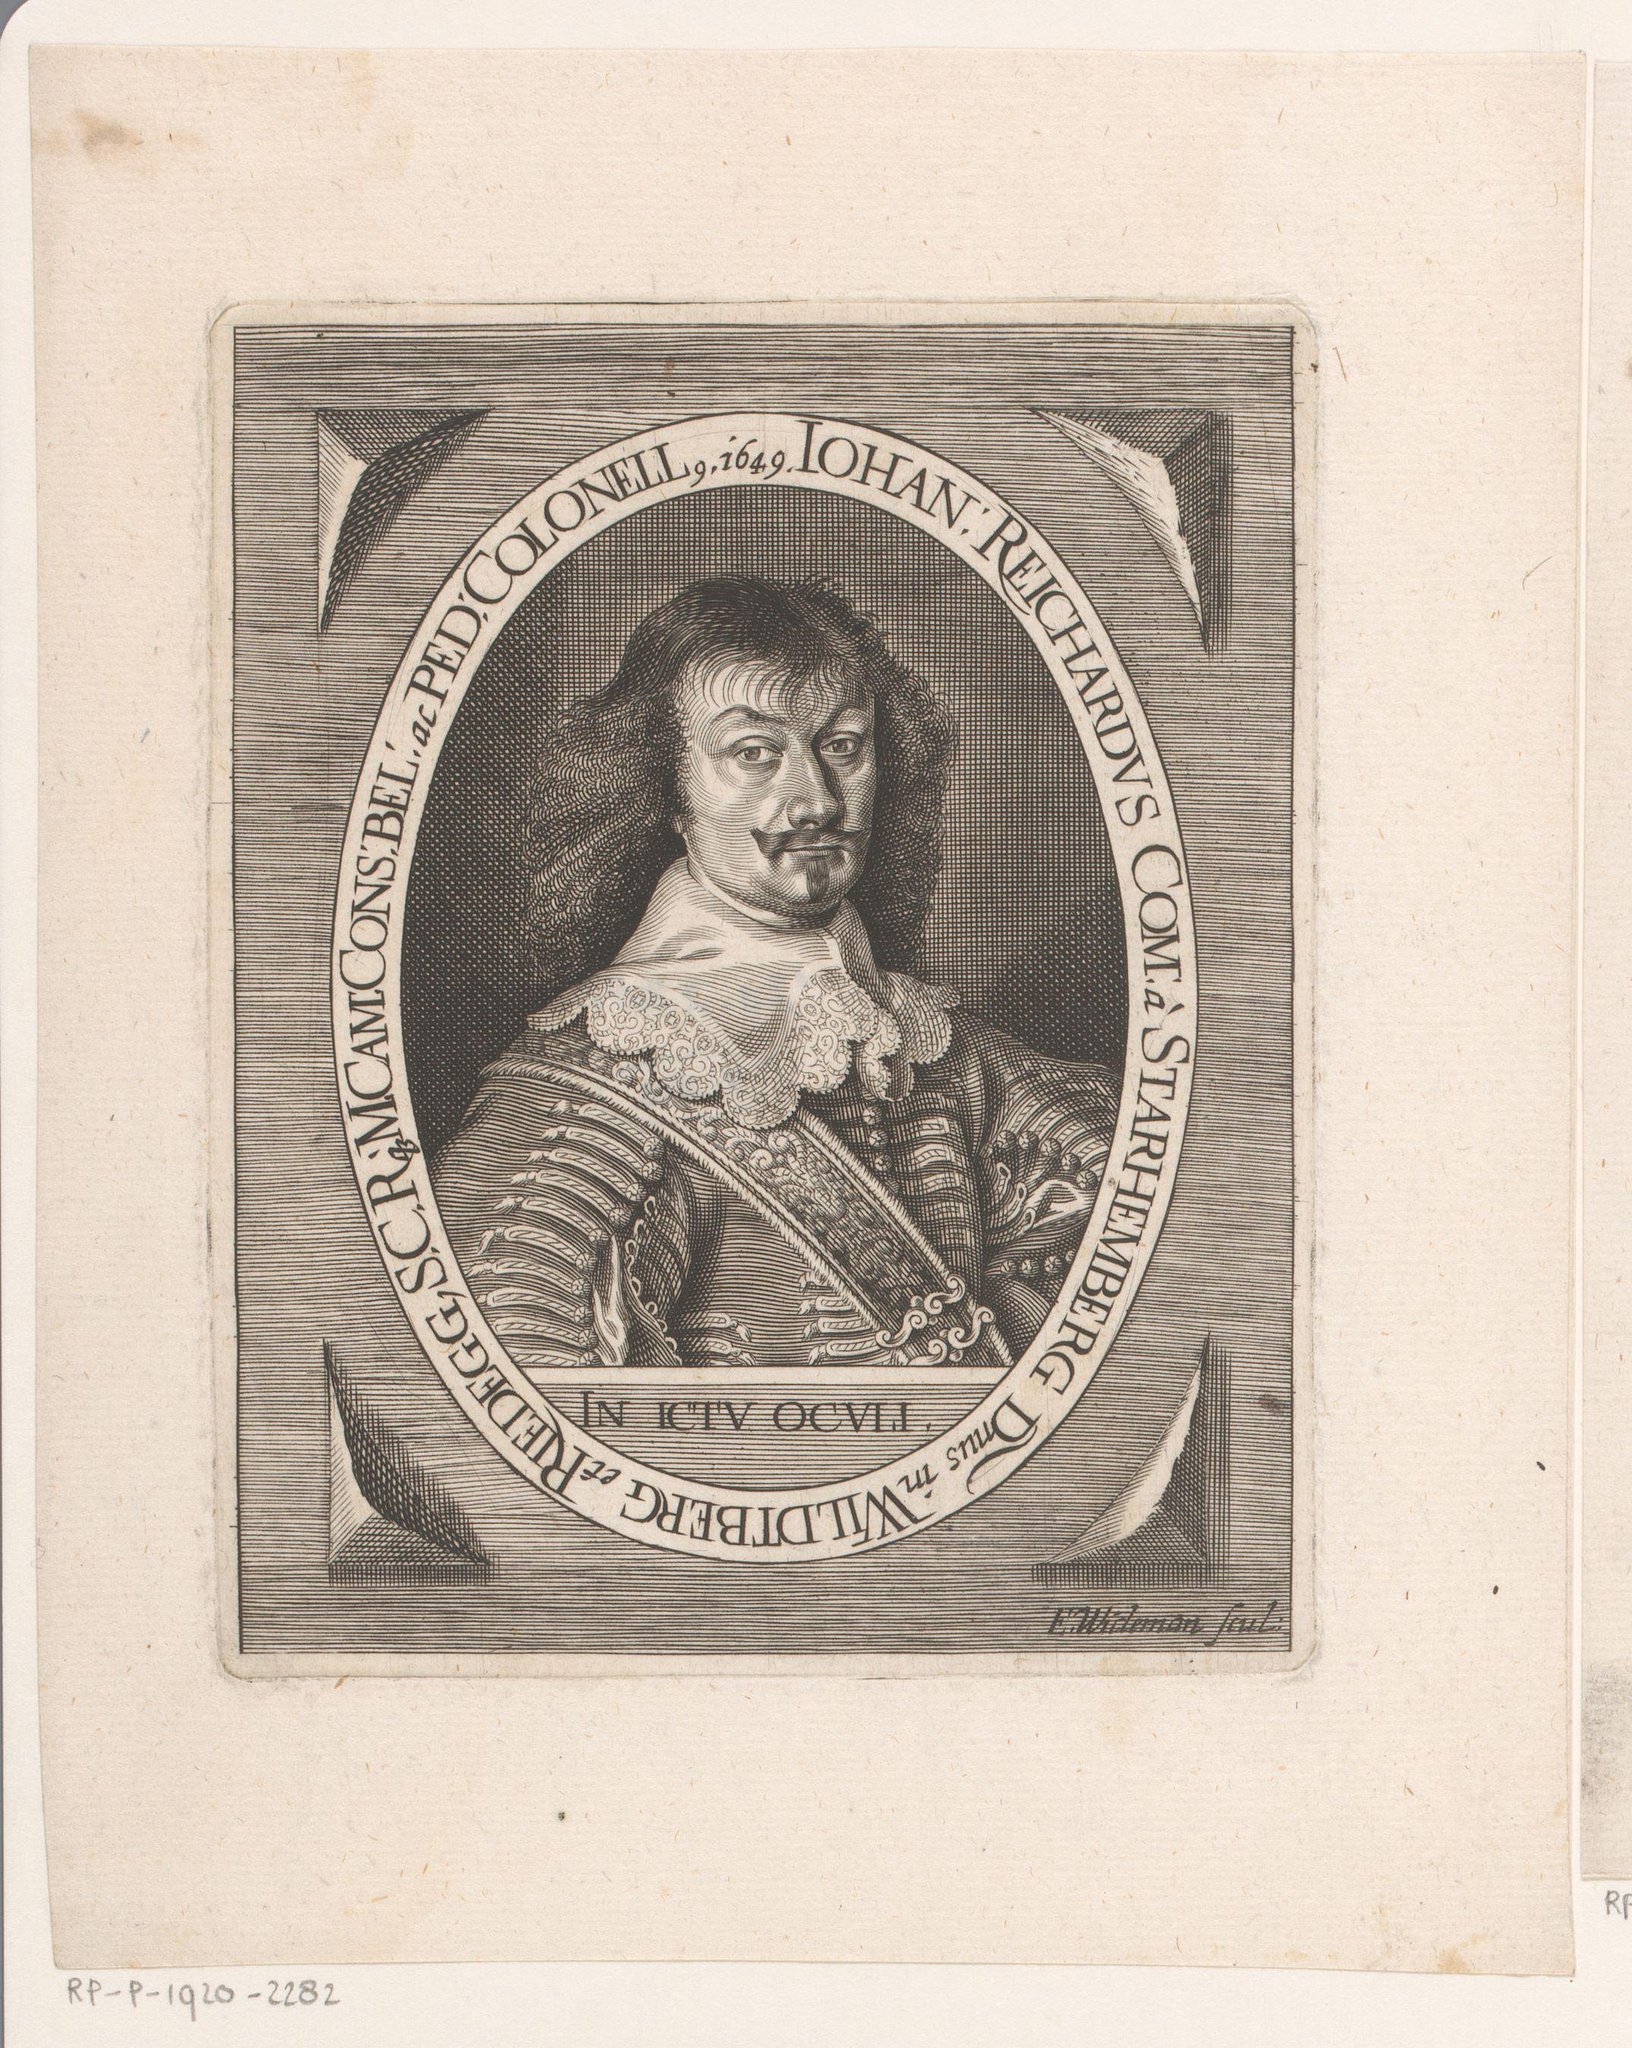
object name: print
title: Portret van Johann Reichard Starhemberg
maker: elias widemann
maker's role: print maker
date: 1649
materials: paper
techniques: engraving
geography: vienna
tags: historical persons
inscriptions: collector's mark: Lugt 2228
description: Prent uit de publicatie: Widemann, Elias. Honori Sacrum. Wenen: s.n., 1649.